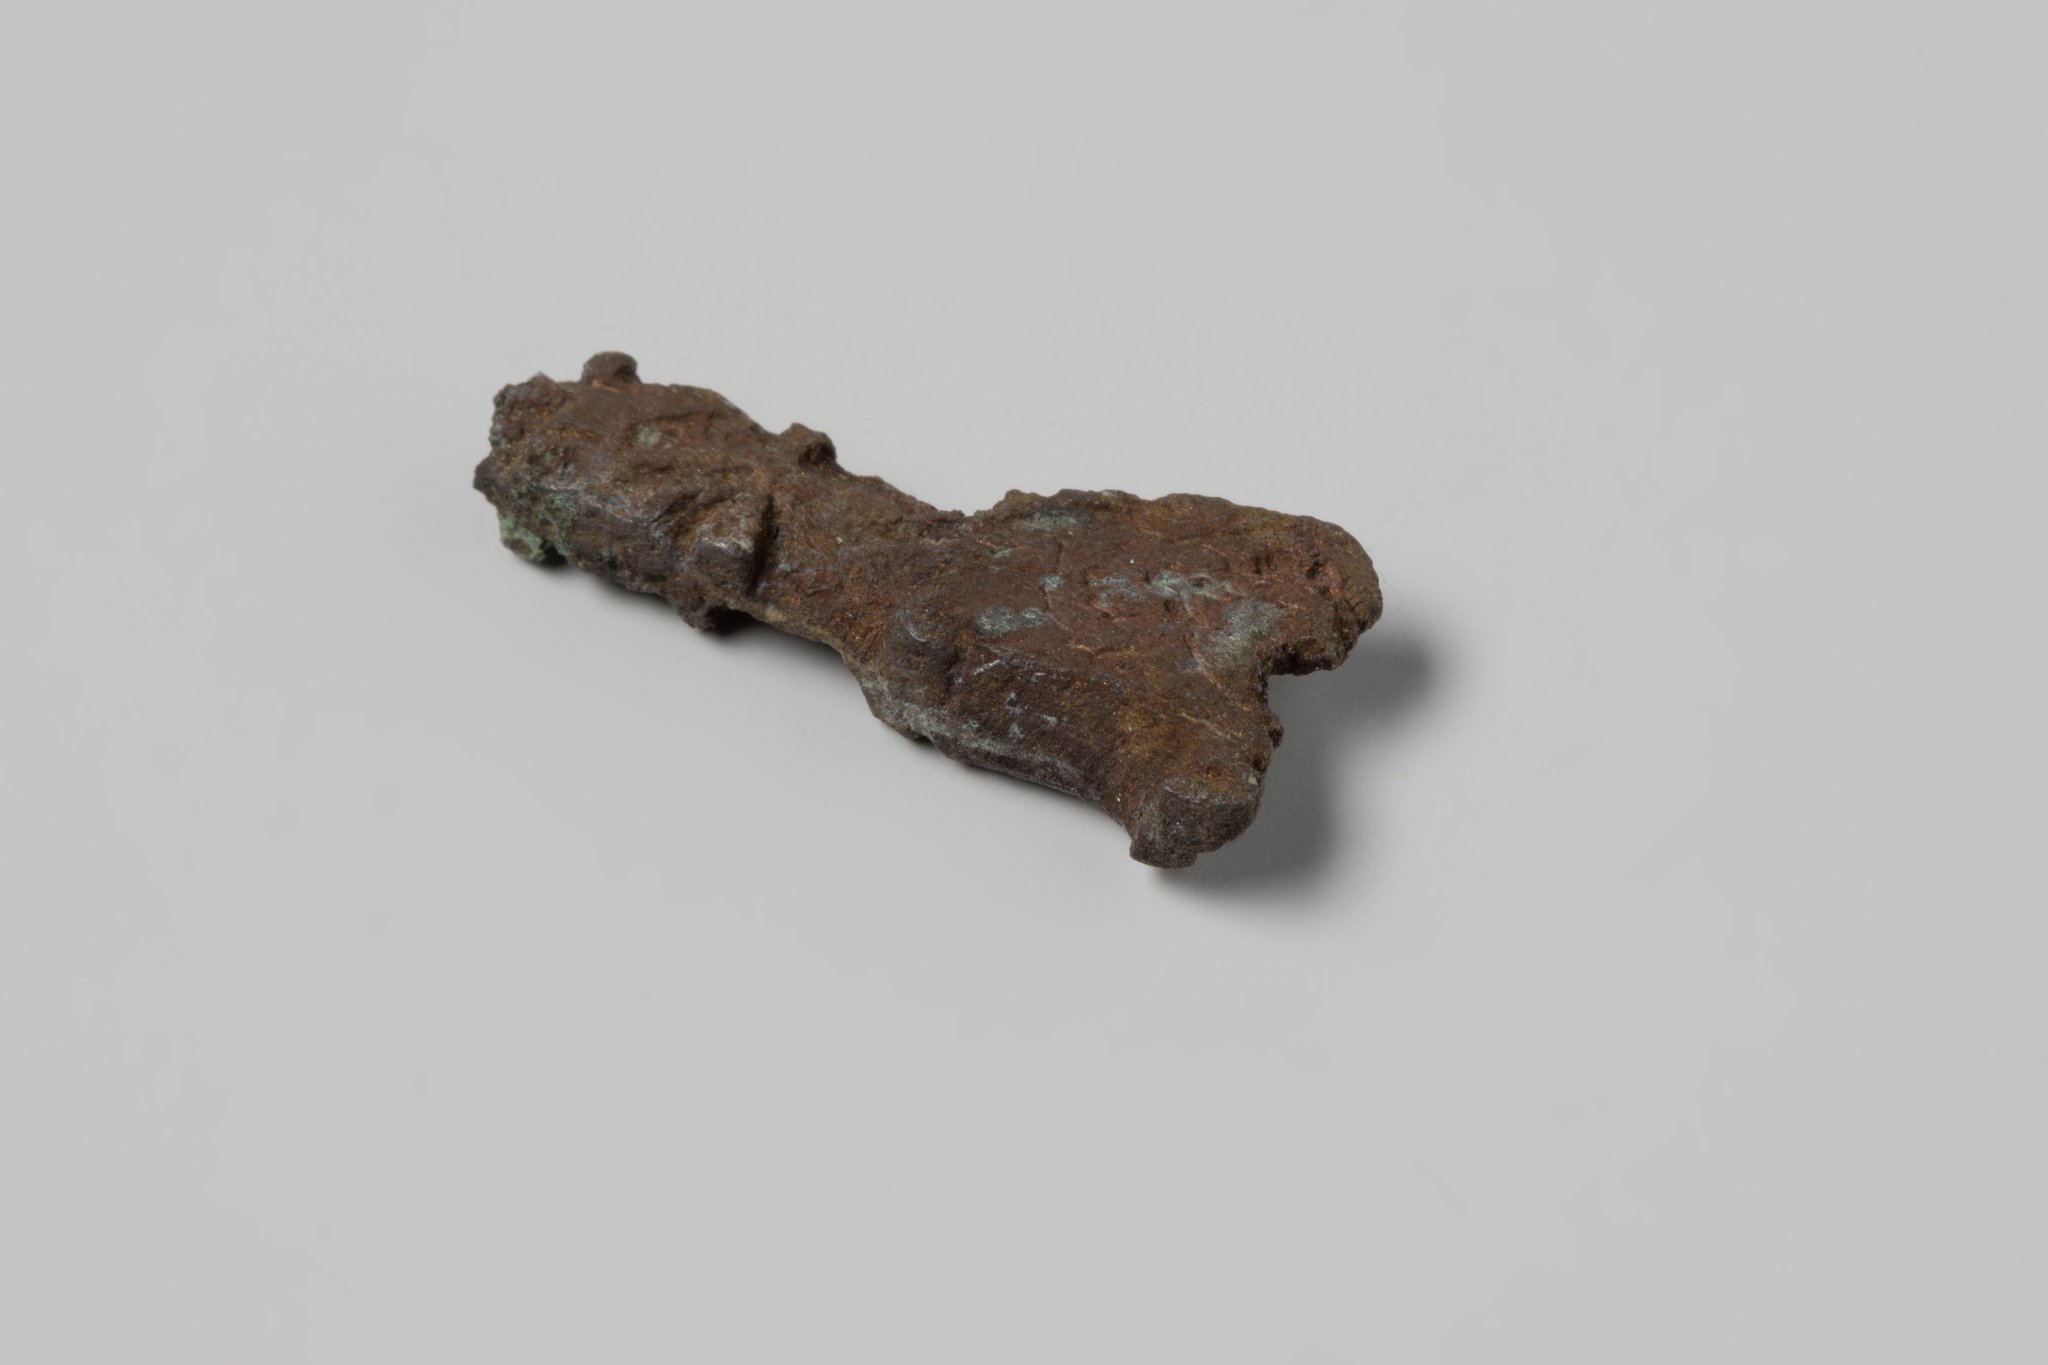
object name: pin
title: Speld uit het wrak van de Oost-Indiëvaarder Hollandia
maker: Anonymous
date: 1700-1743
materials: copper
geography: netherlands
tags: verenigde oostindische compagnie, hollandia (schip), annet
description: Tools and instruments, sewing and sailmaking, pin; fragm of shaft, id. NG 1980-27H3265.